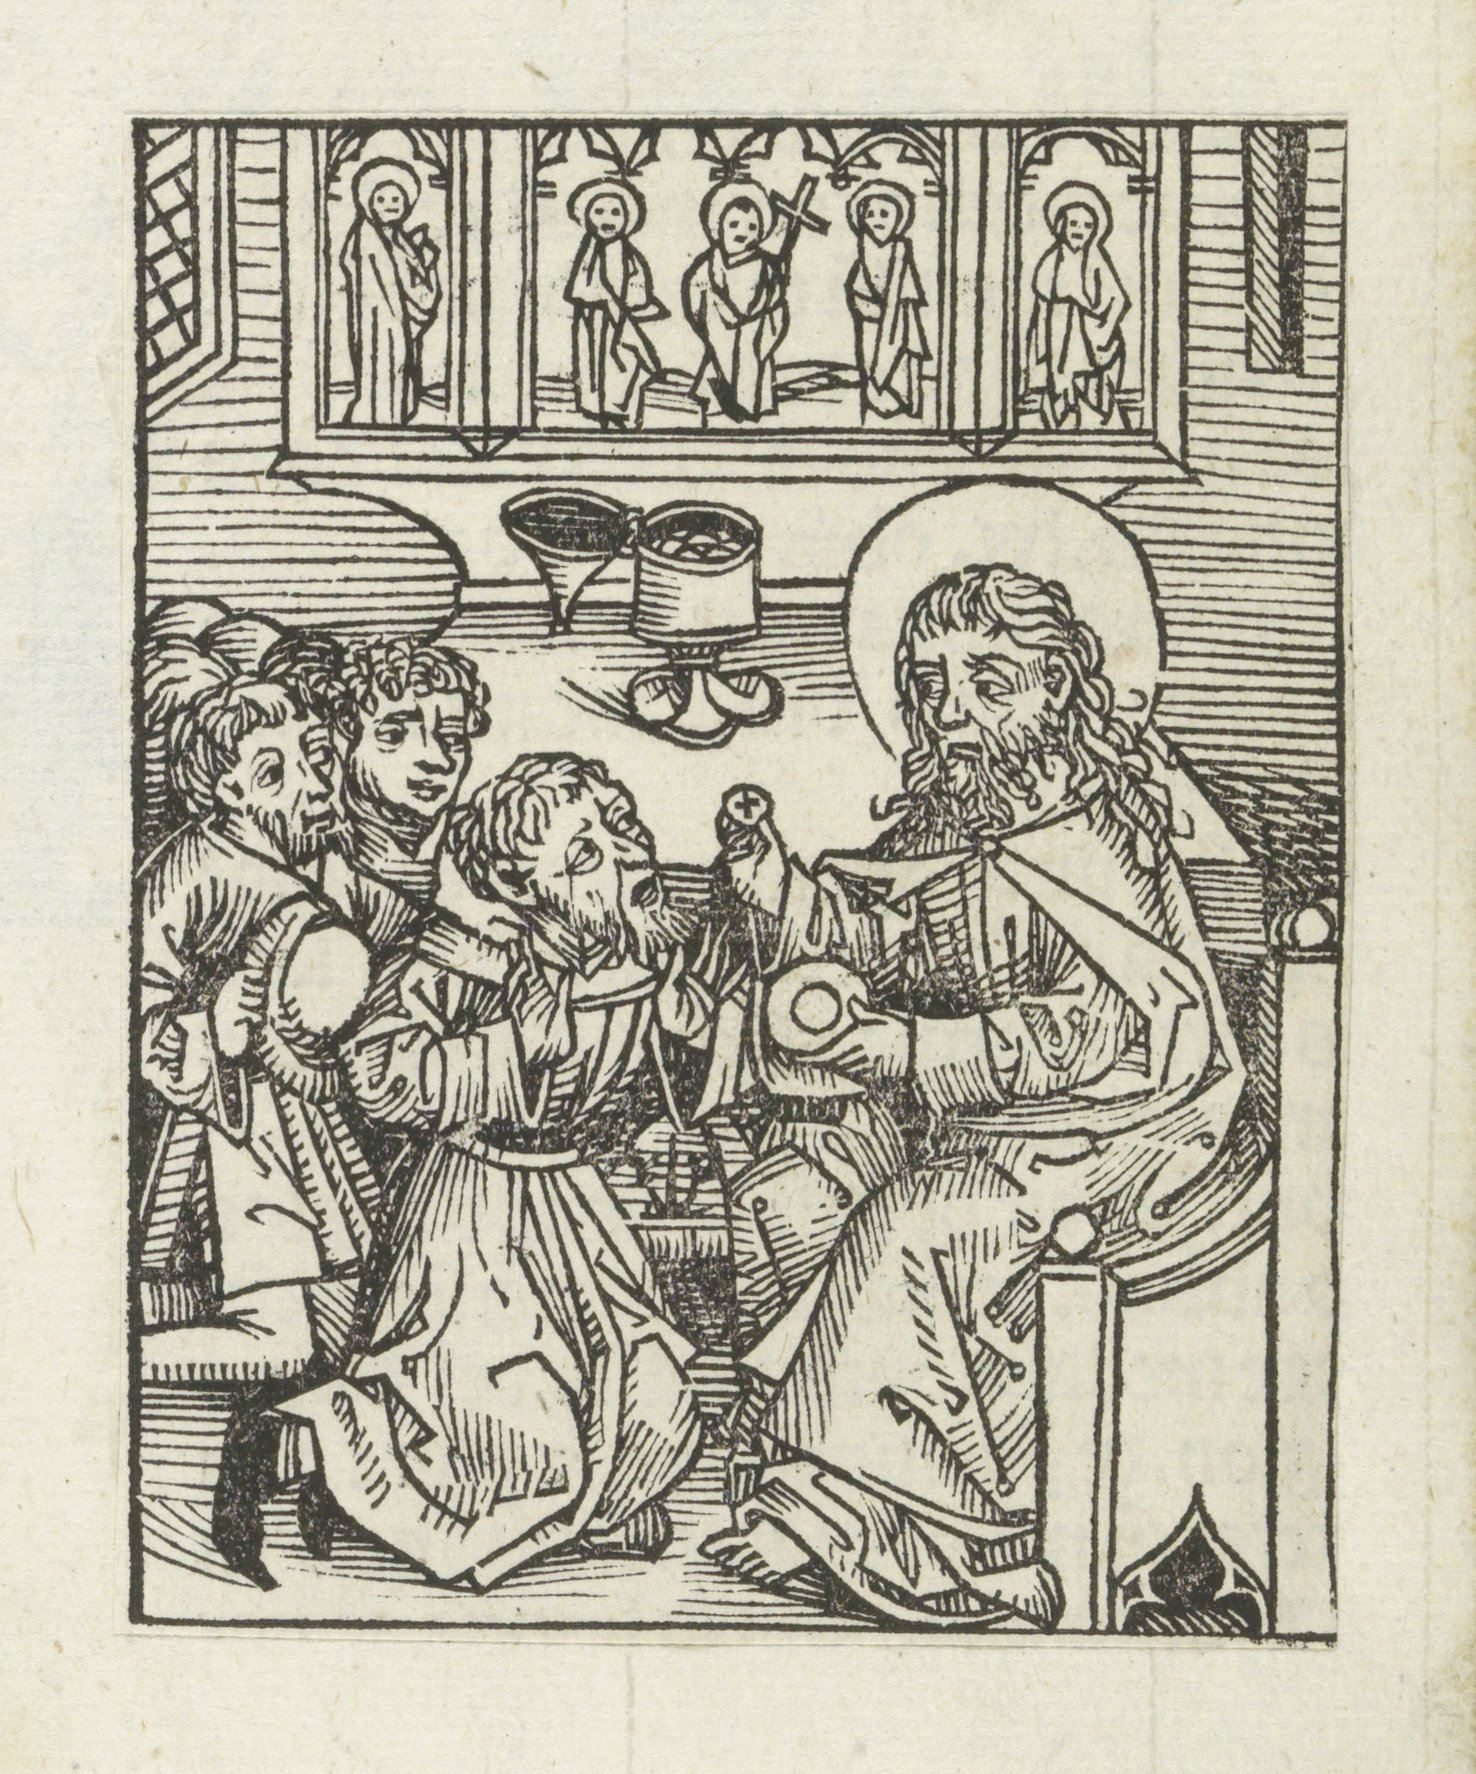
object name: print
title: Uitdelen van de hostie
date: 1493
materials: paper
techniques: letterpress printing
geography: nuremberg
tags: thomas distributes the eucharist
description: De houtsnede wordt gebruikt als boekillustratie in de Liber Chronicarum (of Neurenbergkroniek) van Hartmann Schedel, verschenen in het Latijn en Duits in 1493. Zie de Duitse en Latijnse uitgave, folio 197v.